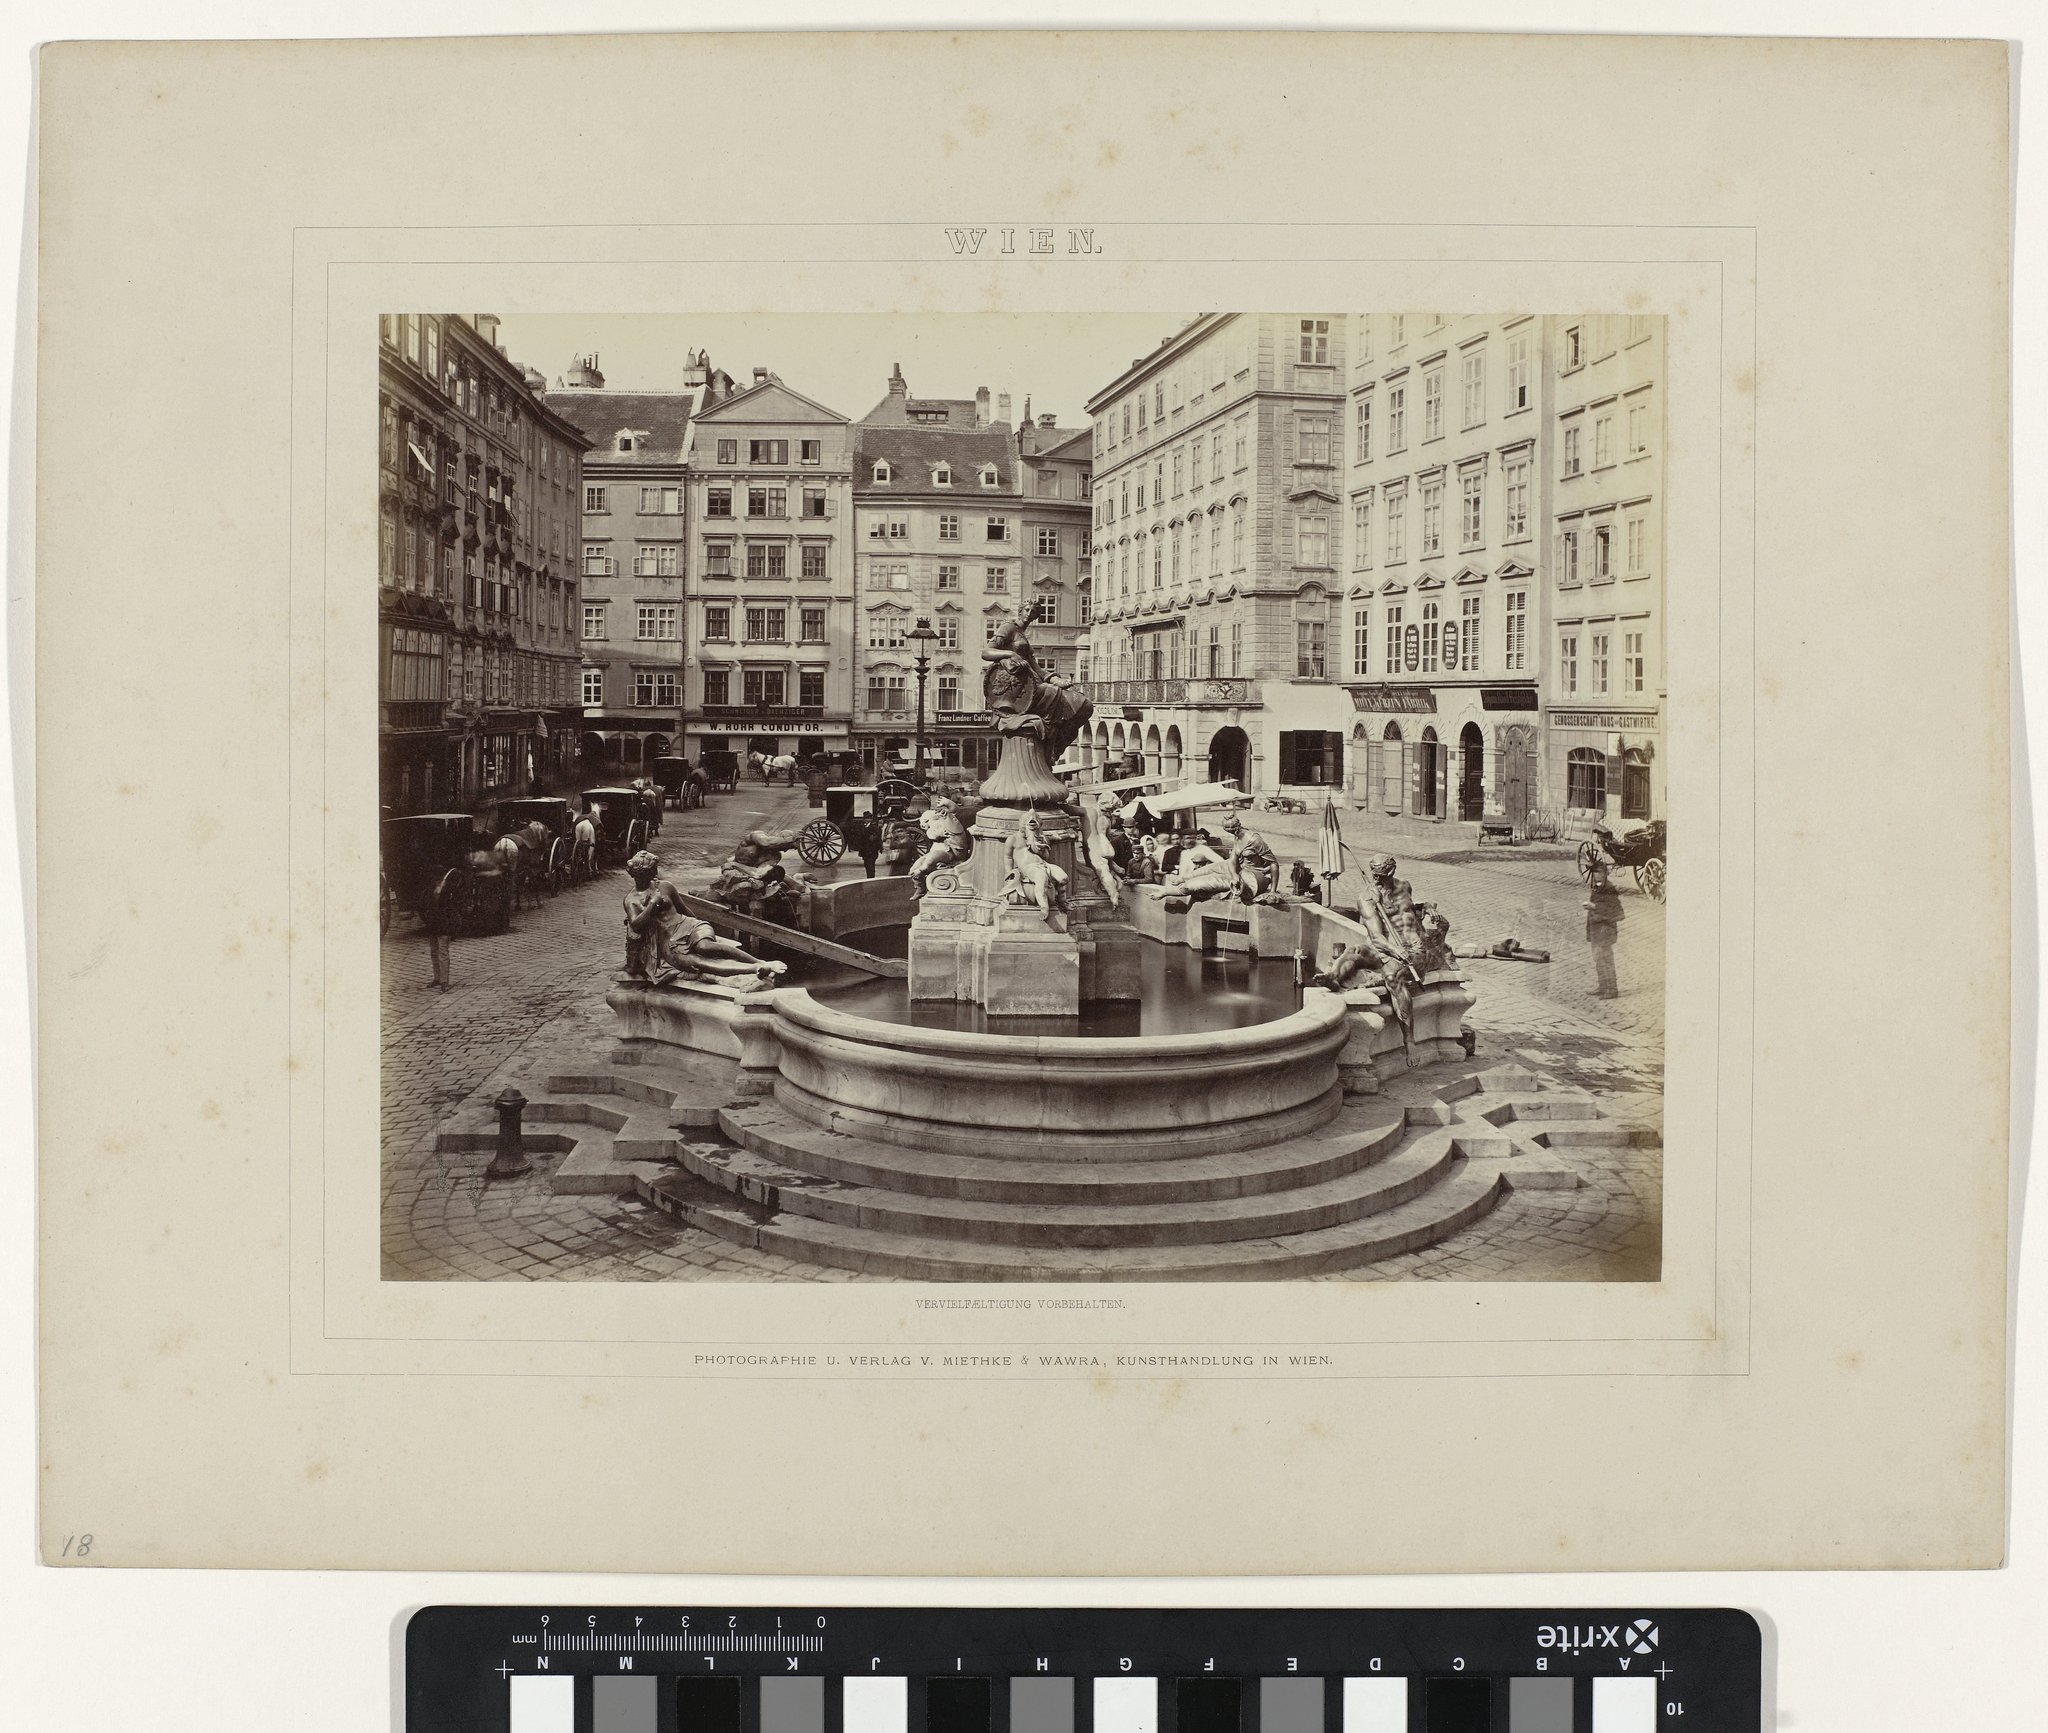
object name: photograph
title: Der neue Markt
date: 1870-1880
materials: cardboard, photographic support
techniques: albumen print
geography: vienna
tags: square, place, circus, etc., ornamental fountain, vienna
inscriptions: inscription: ‘VERVIELFAELTIGUNG VORBEHALTEN.’, signature: ‘Miethke & Wawra’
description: Gezicht op de Neue Markt met de fontein van Georg Raphaël Donner in Wenen